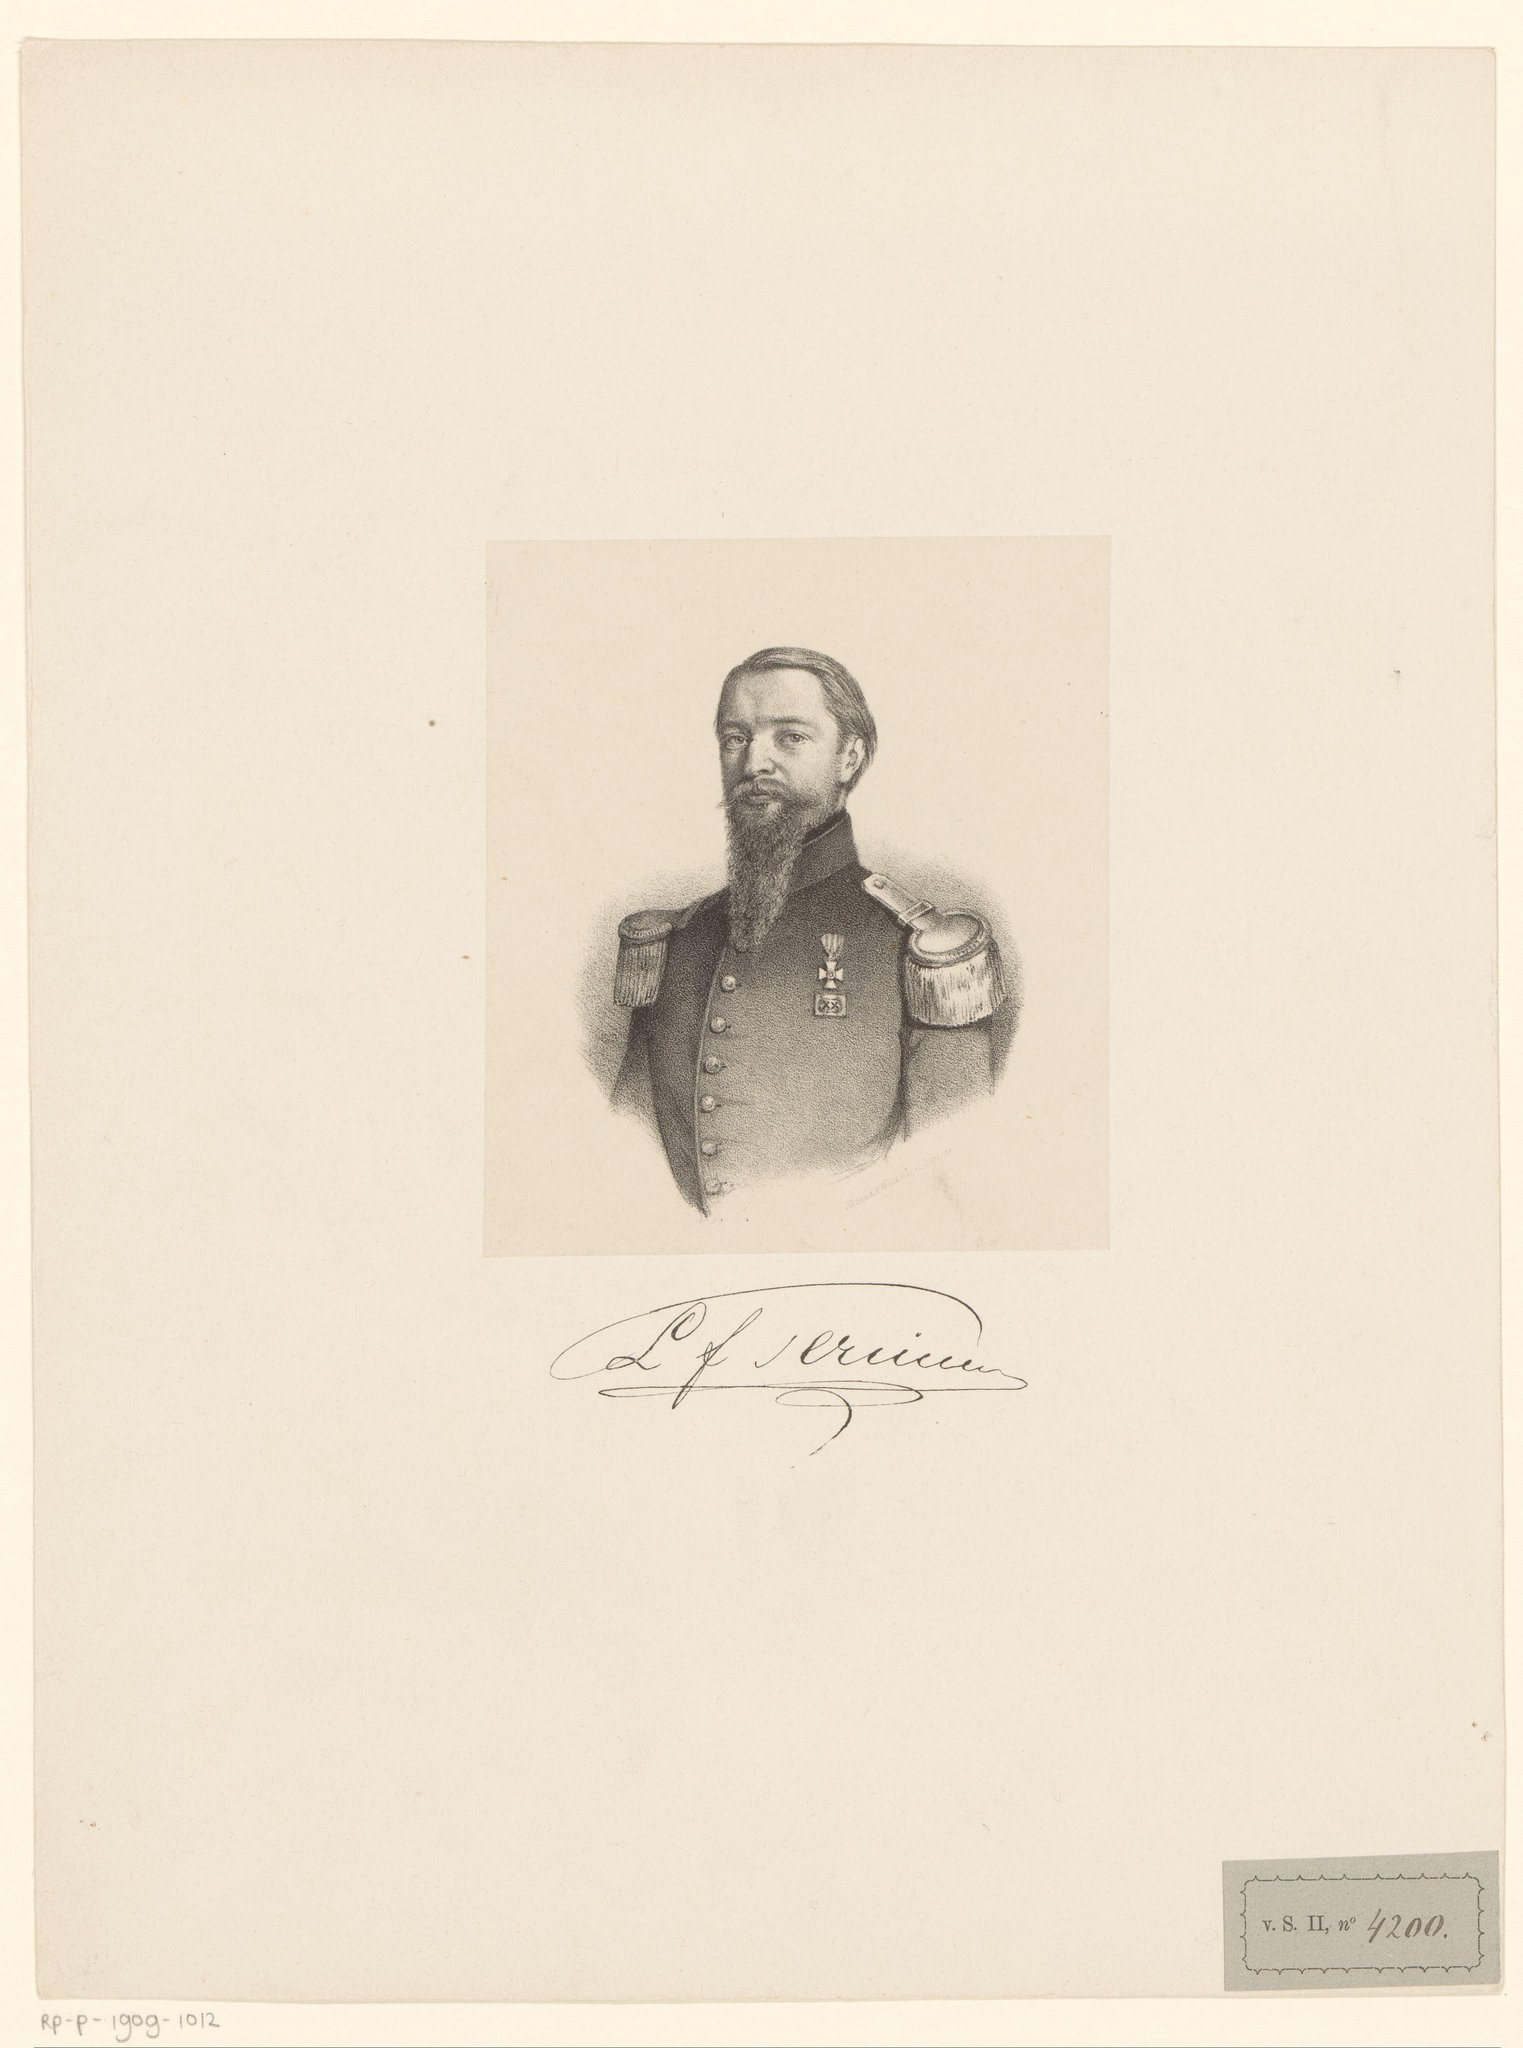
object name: print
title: Portret van L. F. Persille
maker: pieter wilhelmus van de weijer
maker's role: print maker, printer, publisher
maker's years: 1816-1880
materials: paper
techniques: lithograph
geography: utrecht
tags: knighthood order, historical persons (+ (full) bust portrait)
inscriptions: collector's mark: Lugt 2228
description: De geportretteerde draagt een militair uniform met ridderorden en een onderscheiding voor twintigjarige dienst. Onder het portret zijn signatuur.